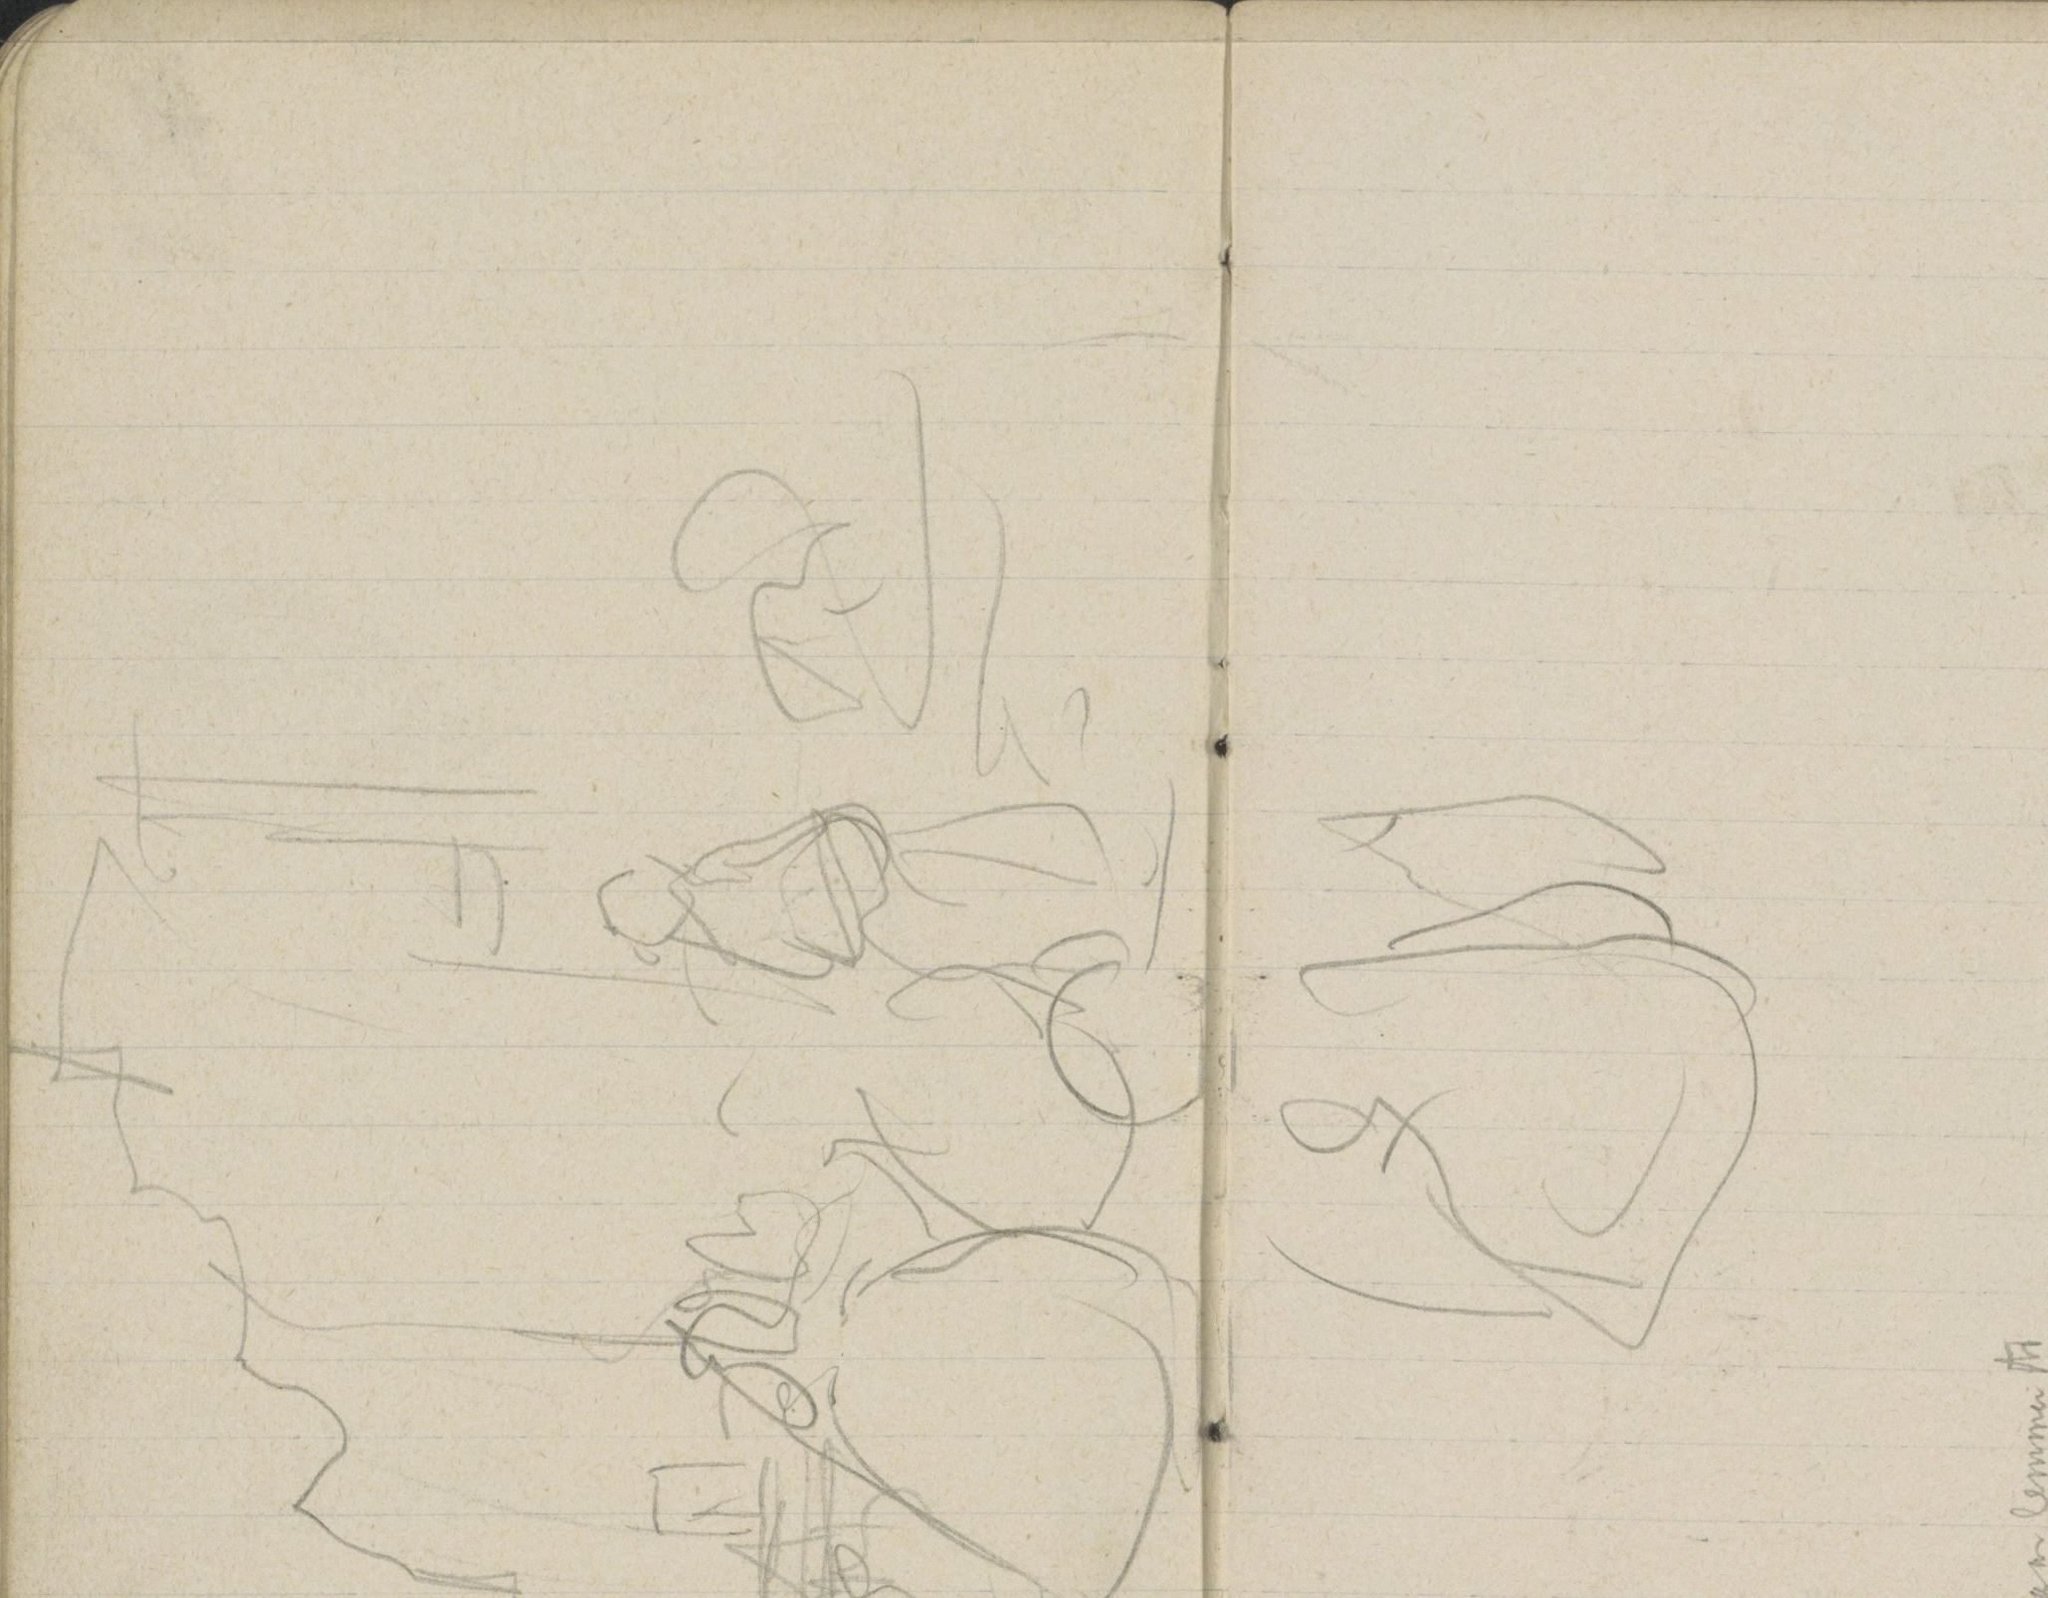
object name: sketchbook leaf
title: Dansende dienstmeiden bij de Haarlemmerstraat in Amsterdam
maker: george hendrik breitner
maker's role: draughtsman, painter, print maker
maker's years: 1857-1923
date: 1903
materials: pencil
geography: amsterdam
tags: dancing, maid ~ house personnel, street (+ city(-scape) with figures, staffage)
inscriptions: annotation: ‘straat Haarlemmerstr,/ dansende meiden 's avonds’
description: Pagina 47 en pagina 48 uit een schetsboek met 32 bladen.